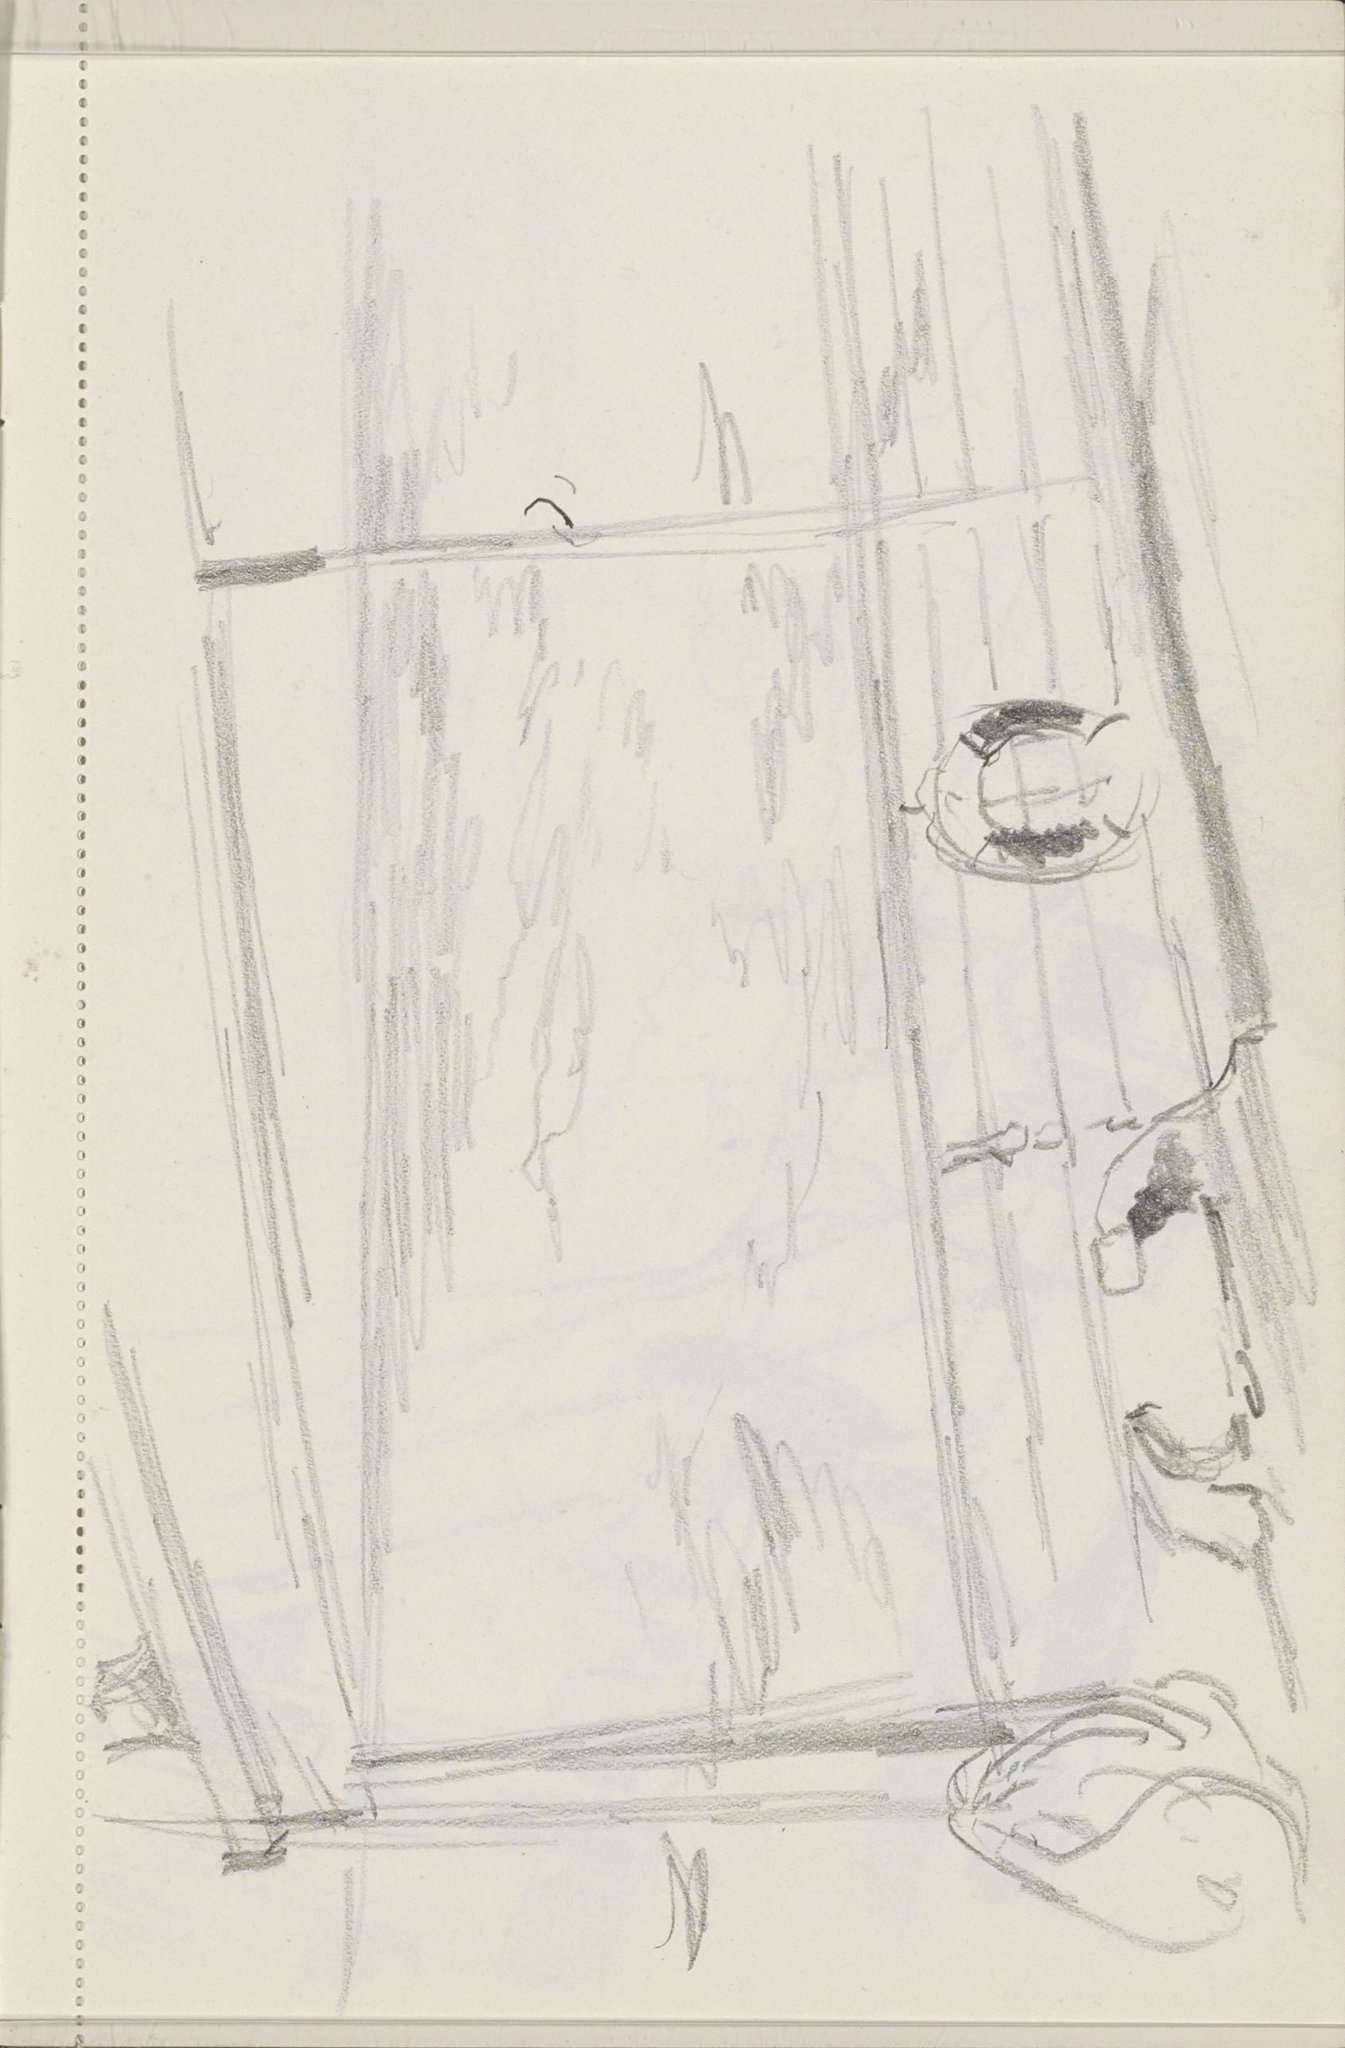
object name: sketchbook leaf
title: Uitzicht op zee vanaf het dek van een zeilschip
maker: cornelis vreedenburgh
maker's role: draughtsman, print maker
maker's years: 1880-1946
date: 1936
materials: paper, pencil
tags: parts of ship's exterior: deck, sea (seascape)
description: Blad 21 recto uit een schetsboek met 73 bladen.